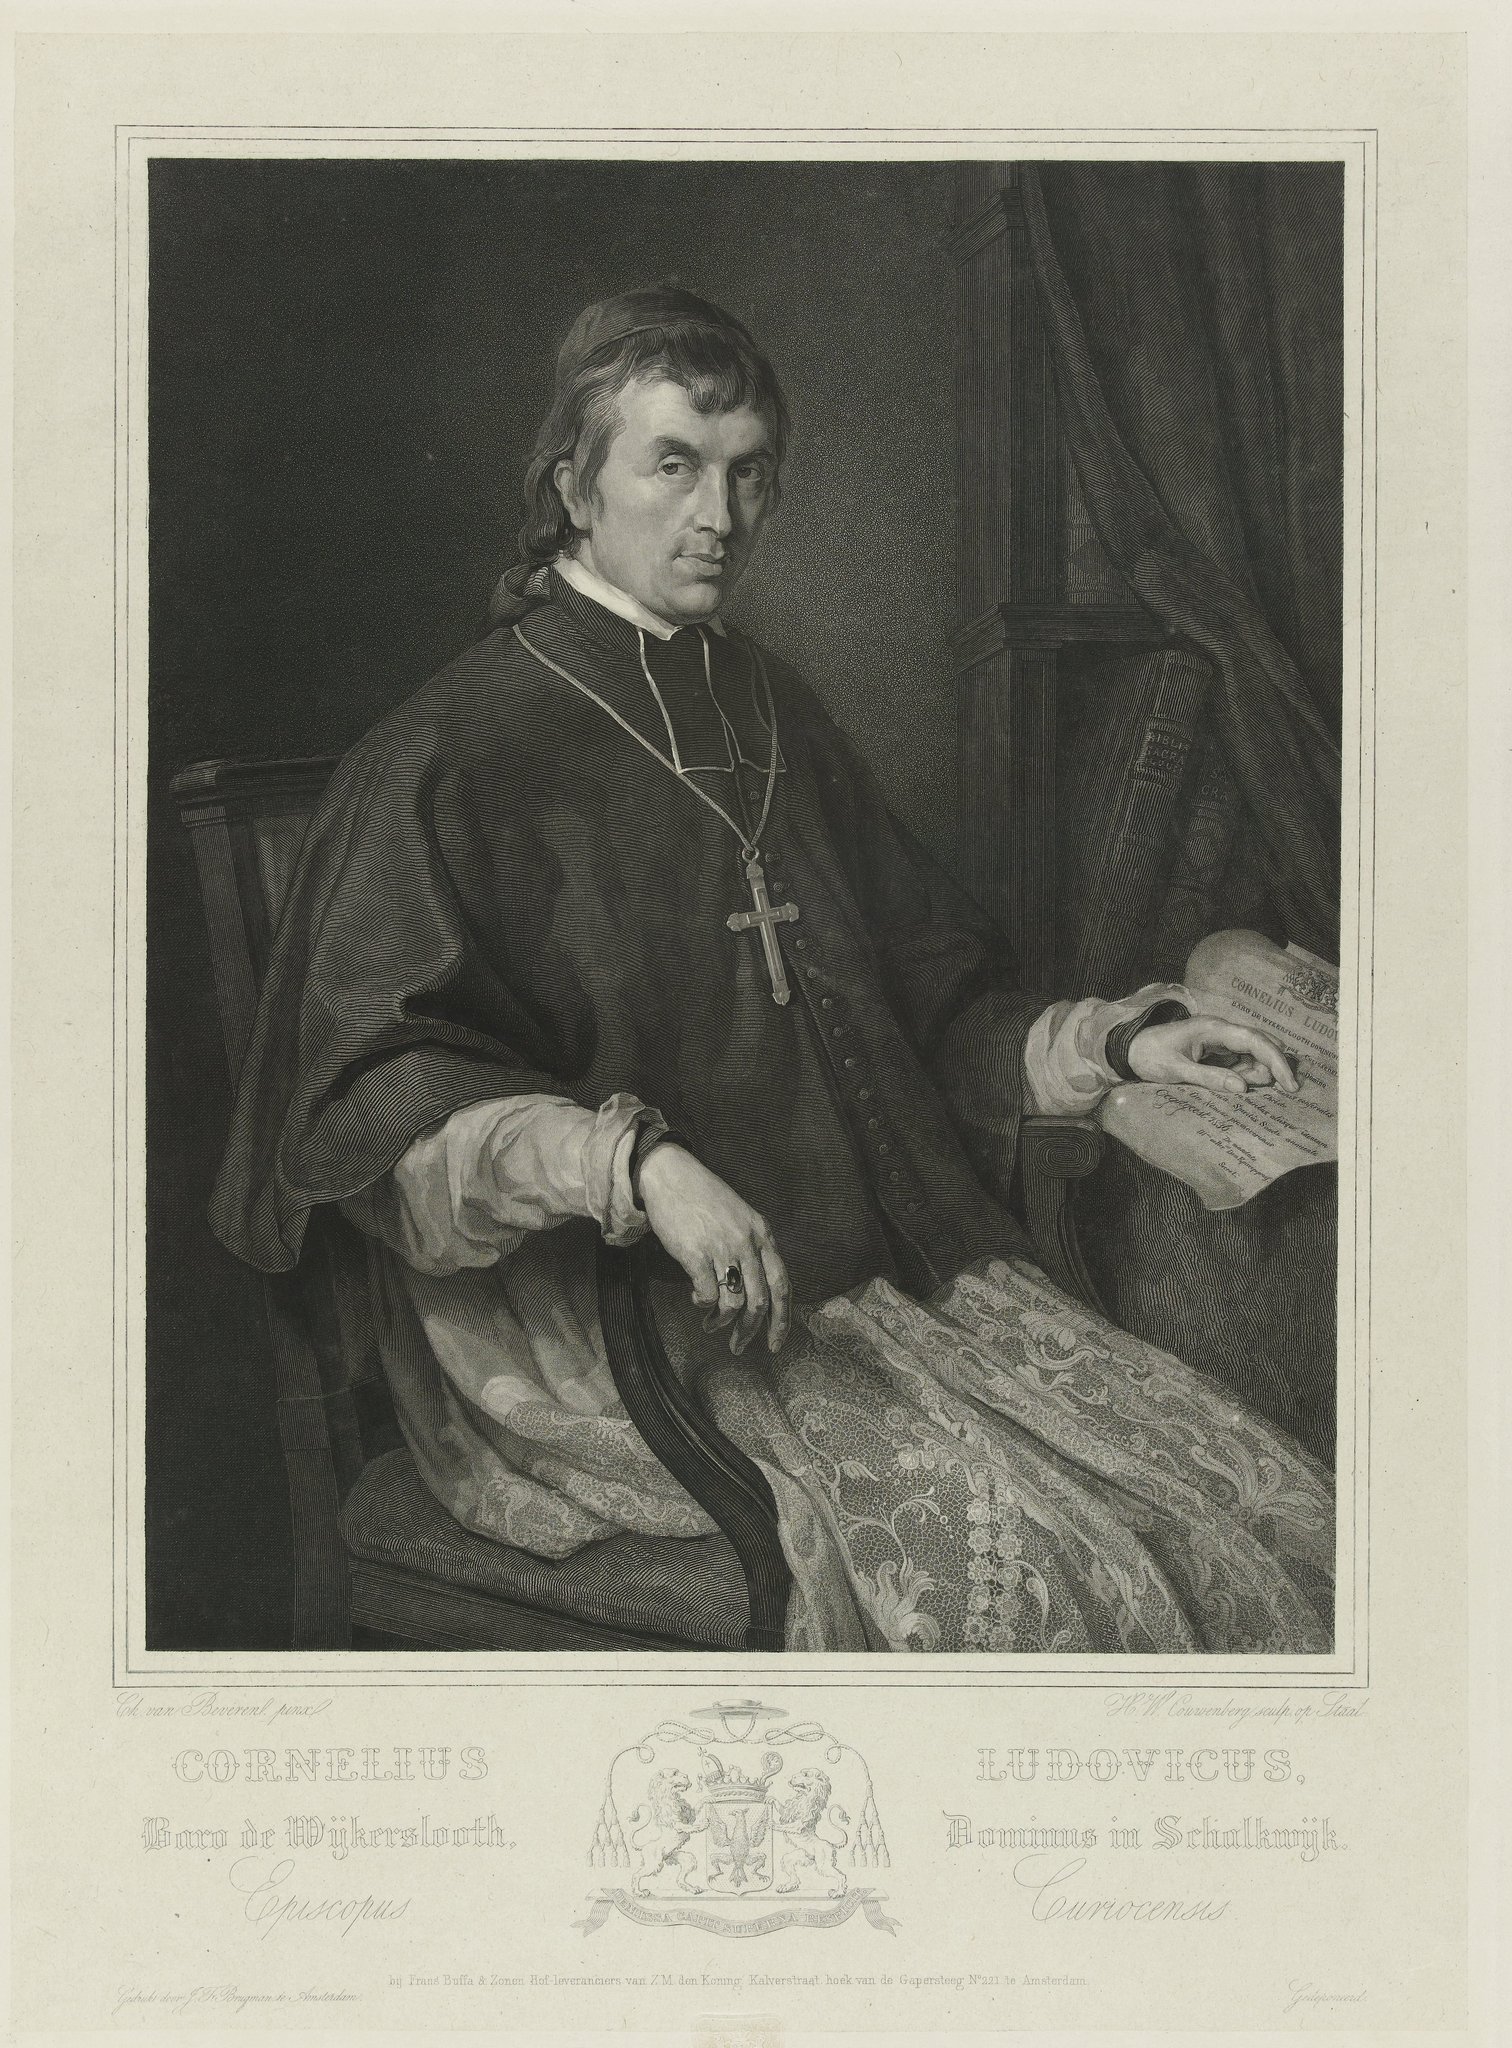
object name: print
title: Portret van Cornelius Ludovicus baron van Wijkerslooth bisschop van Curium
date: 1837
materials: paper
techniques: aquatint, engraving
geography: amsterdam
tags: c.l. wijckersloot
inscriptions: collector's mark: Lugt 12